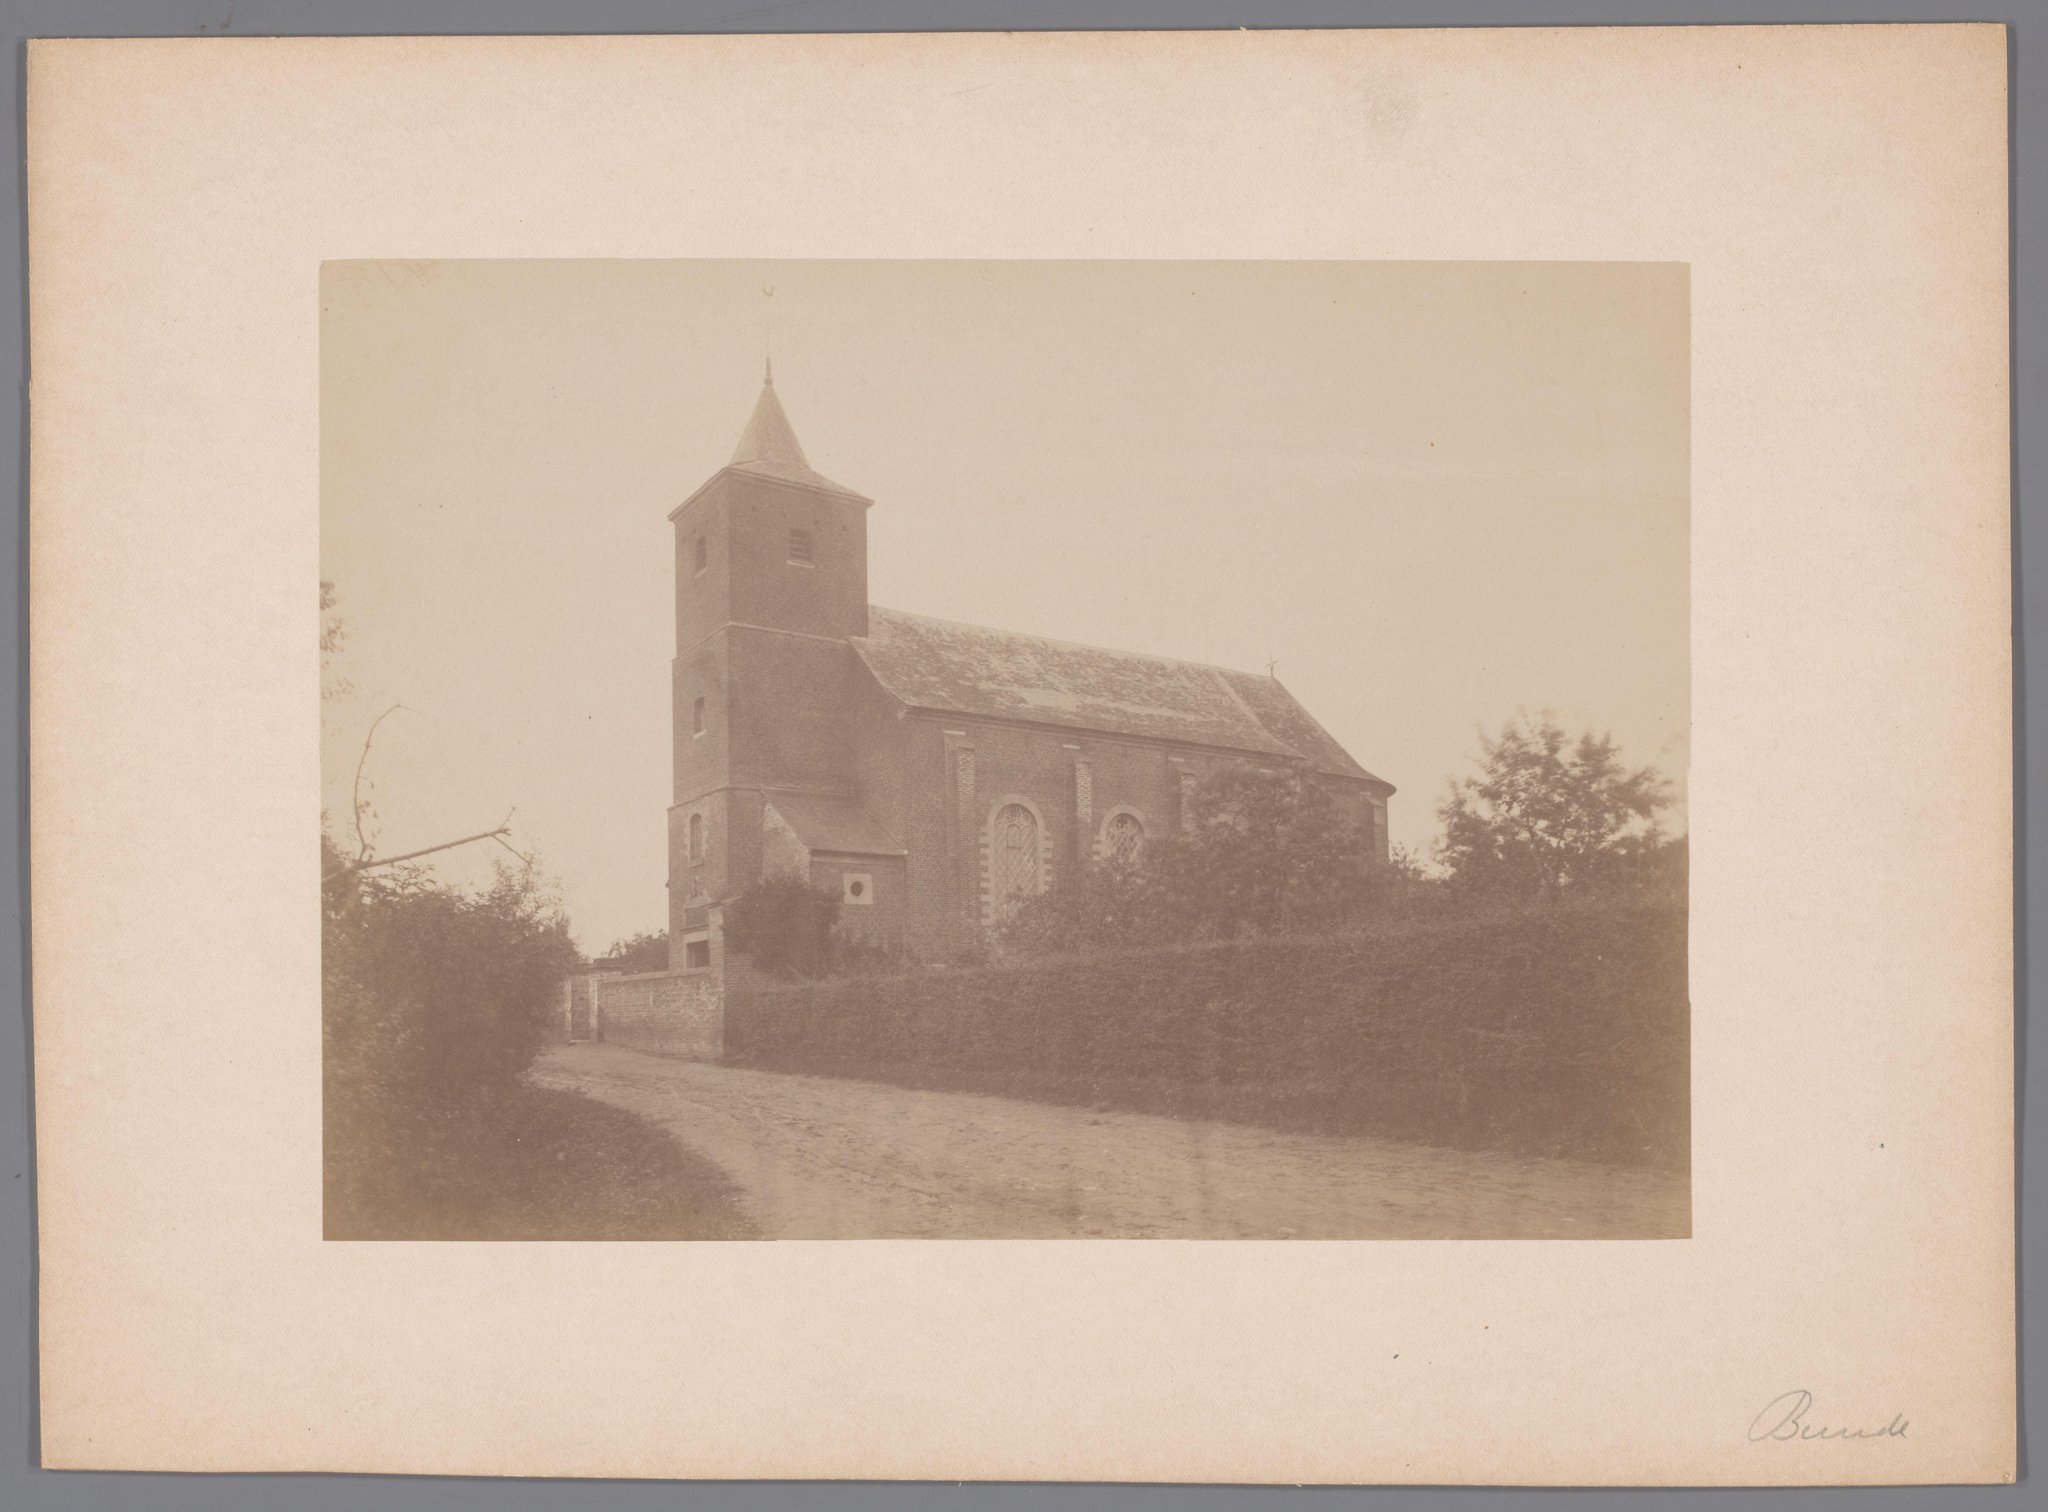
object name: photograph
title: Gezicht op de Rooms-Katholieke Kerk te Bunde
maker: anoniem (monumentenzorg)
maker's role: fotograaf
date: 1904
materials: cardboard, photographic support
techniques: albumen print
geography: bunde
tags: church (exterior)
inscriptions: annotation: ‘Bunde bij Maastricht/ R.K. Kerk oct 1904’, annotation: ‘Bunde’